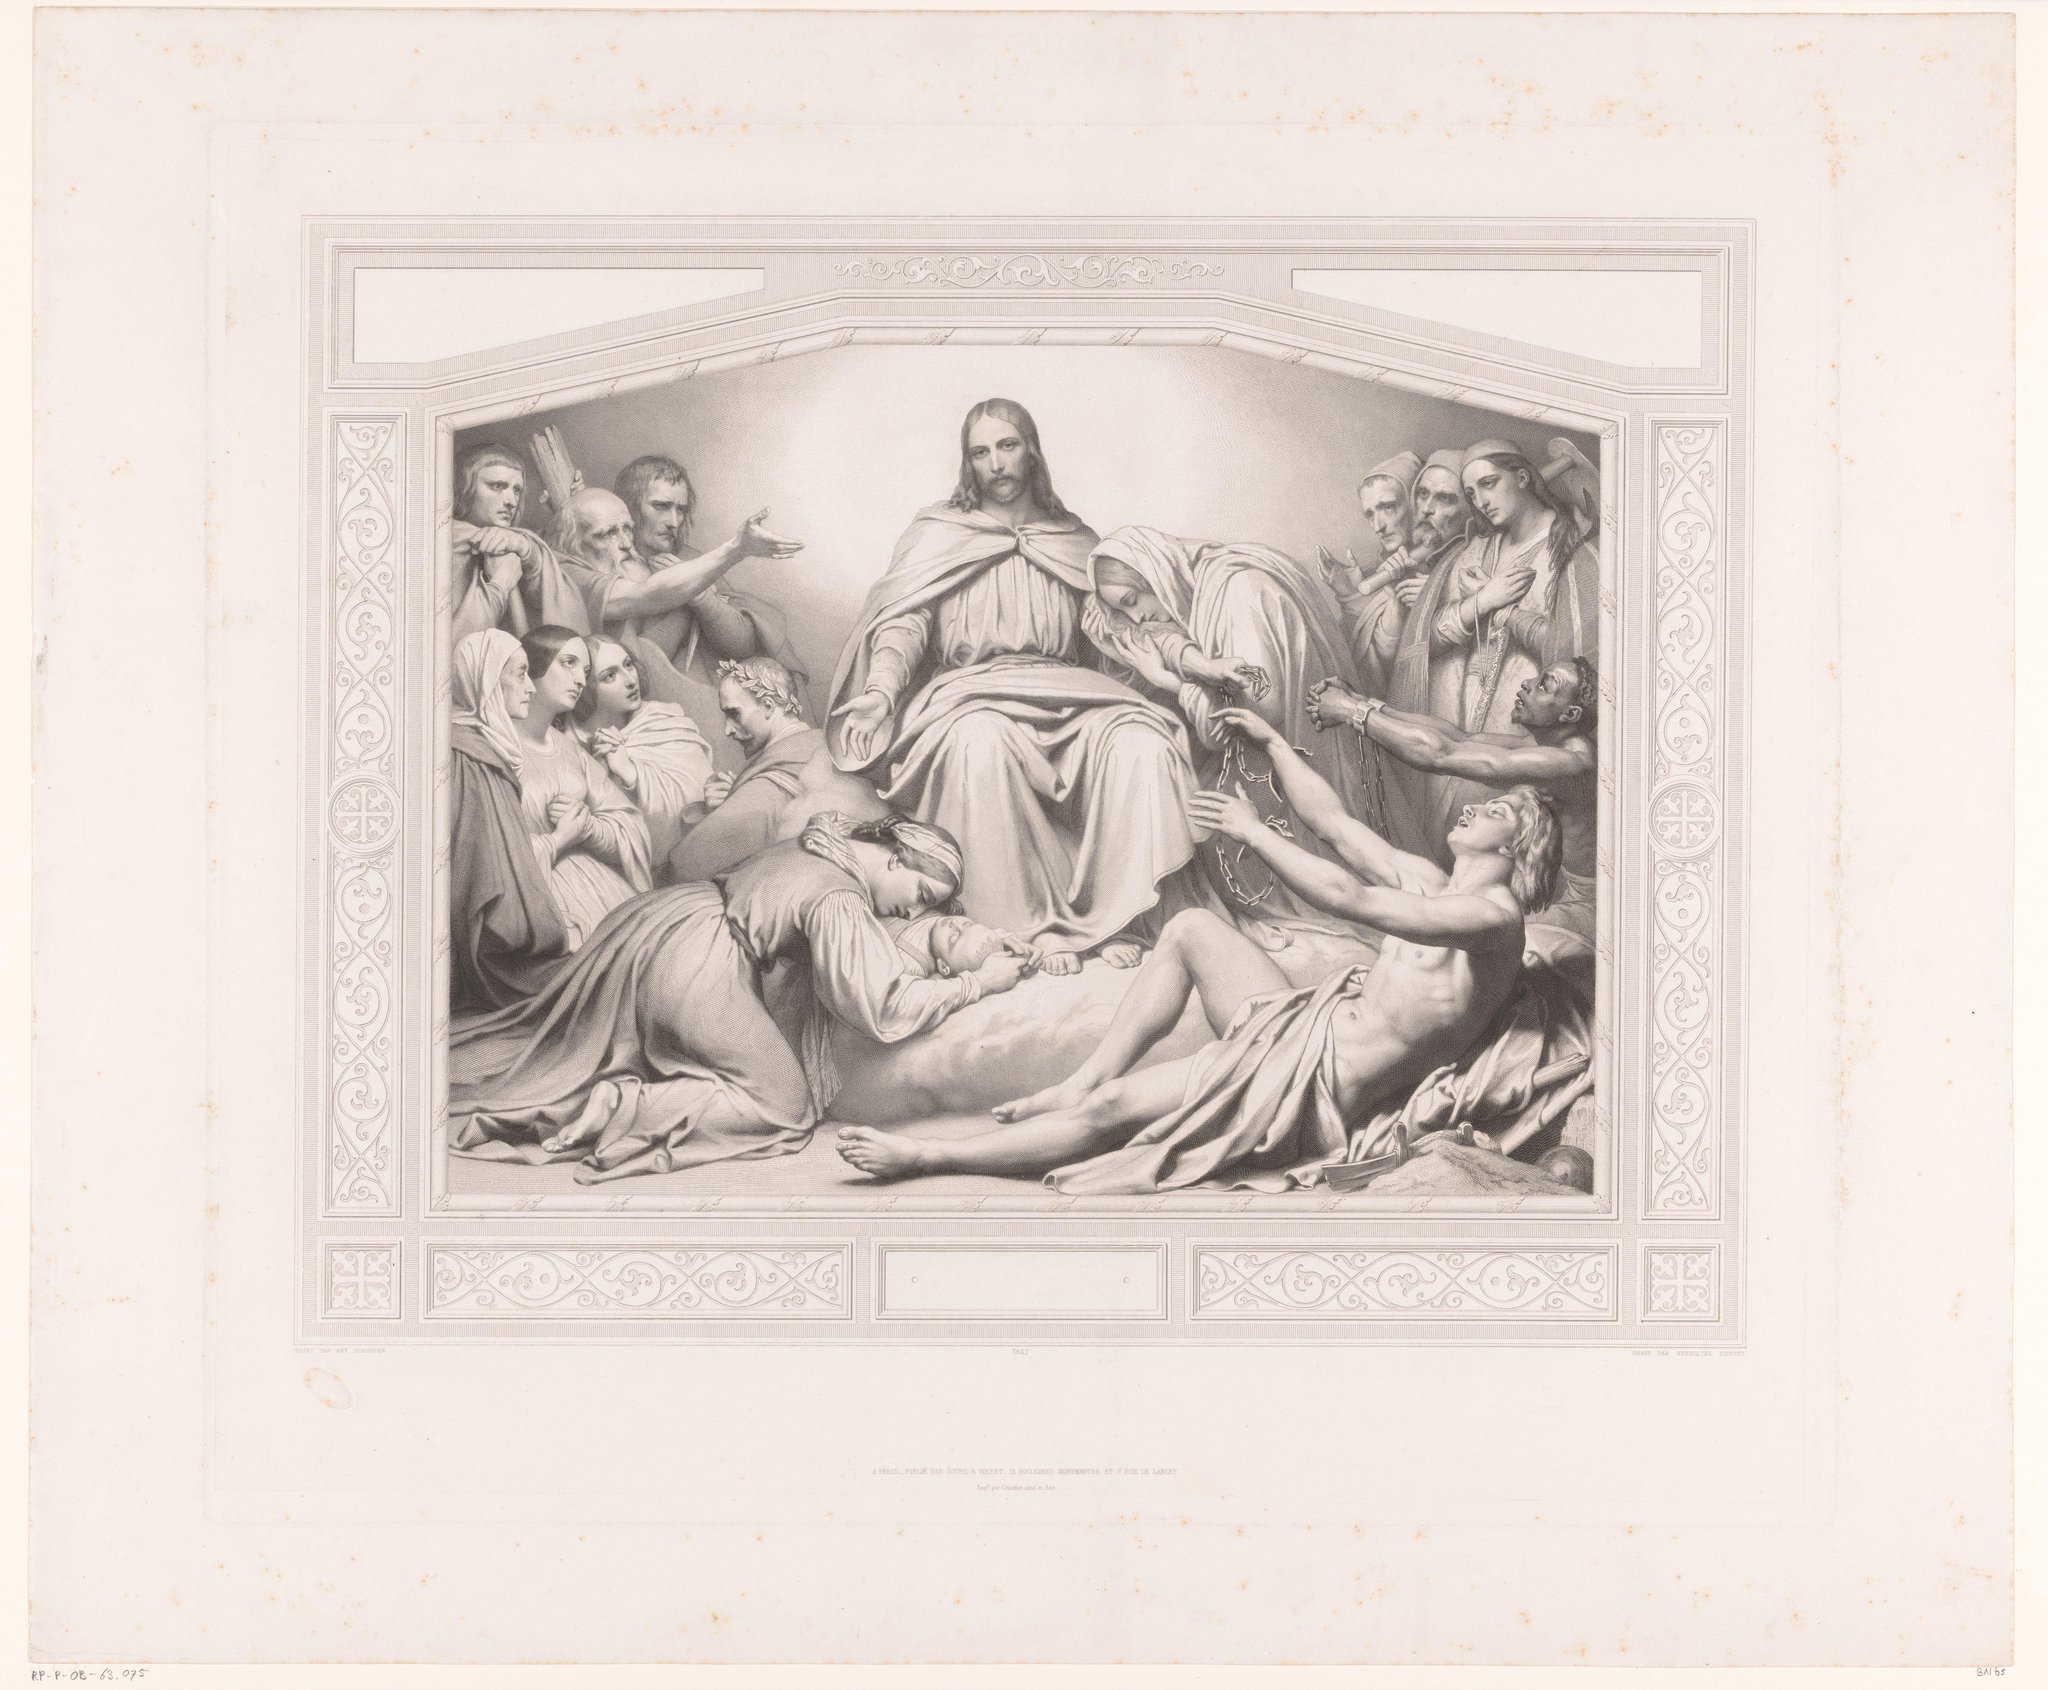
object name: print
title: Christus Consolator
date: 1840-1842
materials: paper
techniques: engraving, etching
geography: paris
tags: consolation, consoling the sorrowful ~ one of the (seven) spiritual acts of mercy - vv - christ present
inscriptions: collector's mark: Lugt 12, check stamp: Lugt 5078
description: Het schilderij bevindt zich in de collectie van het Dordrechts Museum, inv.nr. DM/S/55.